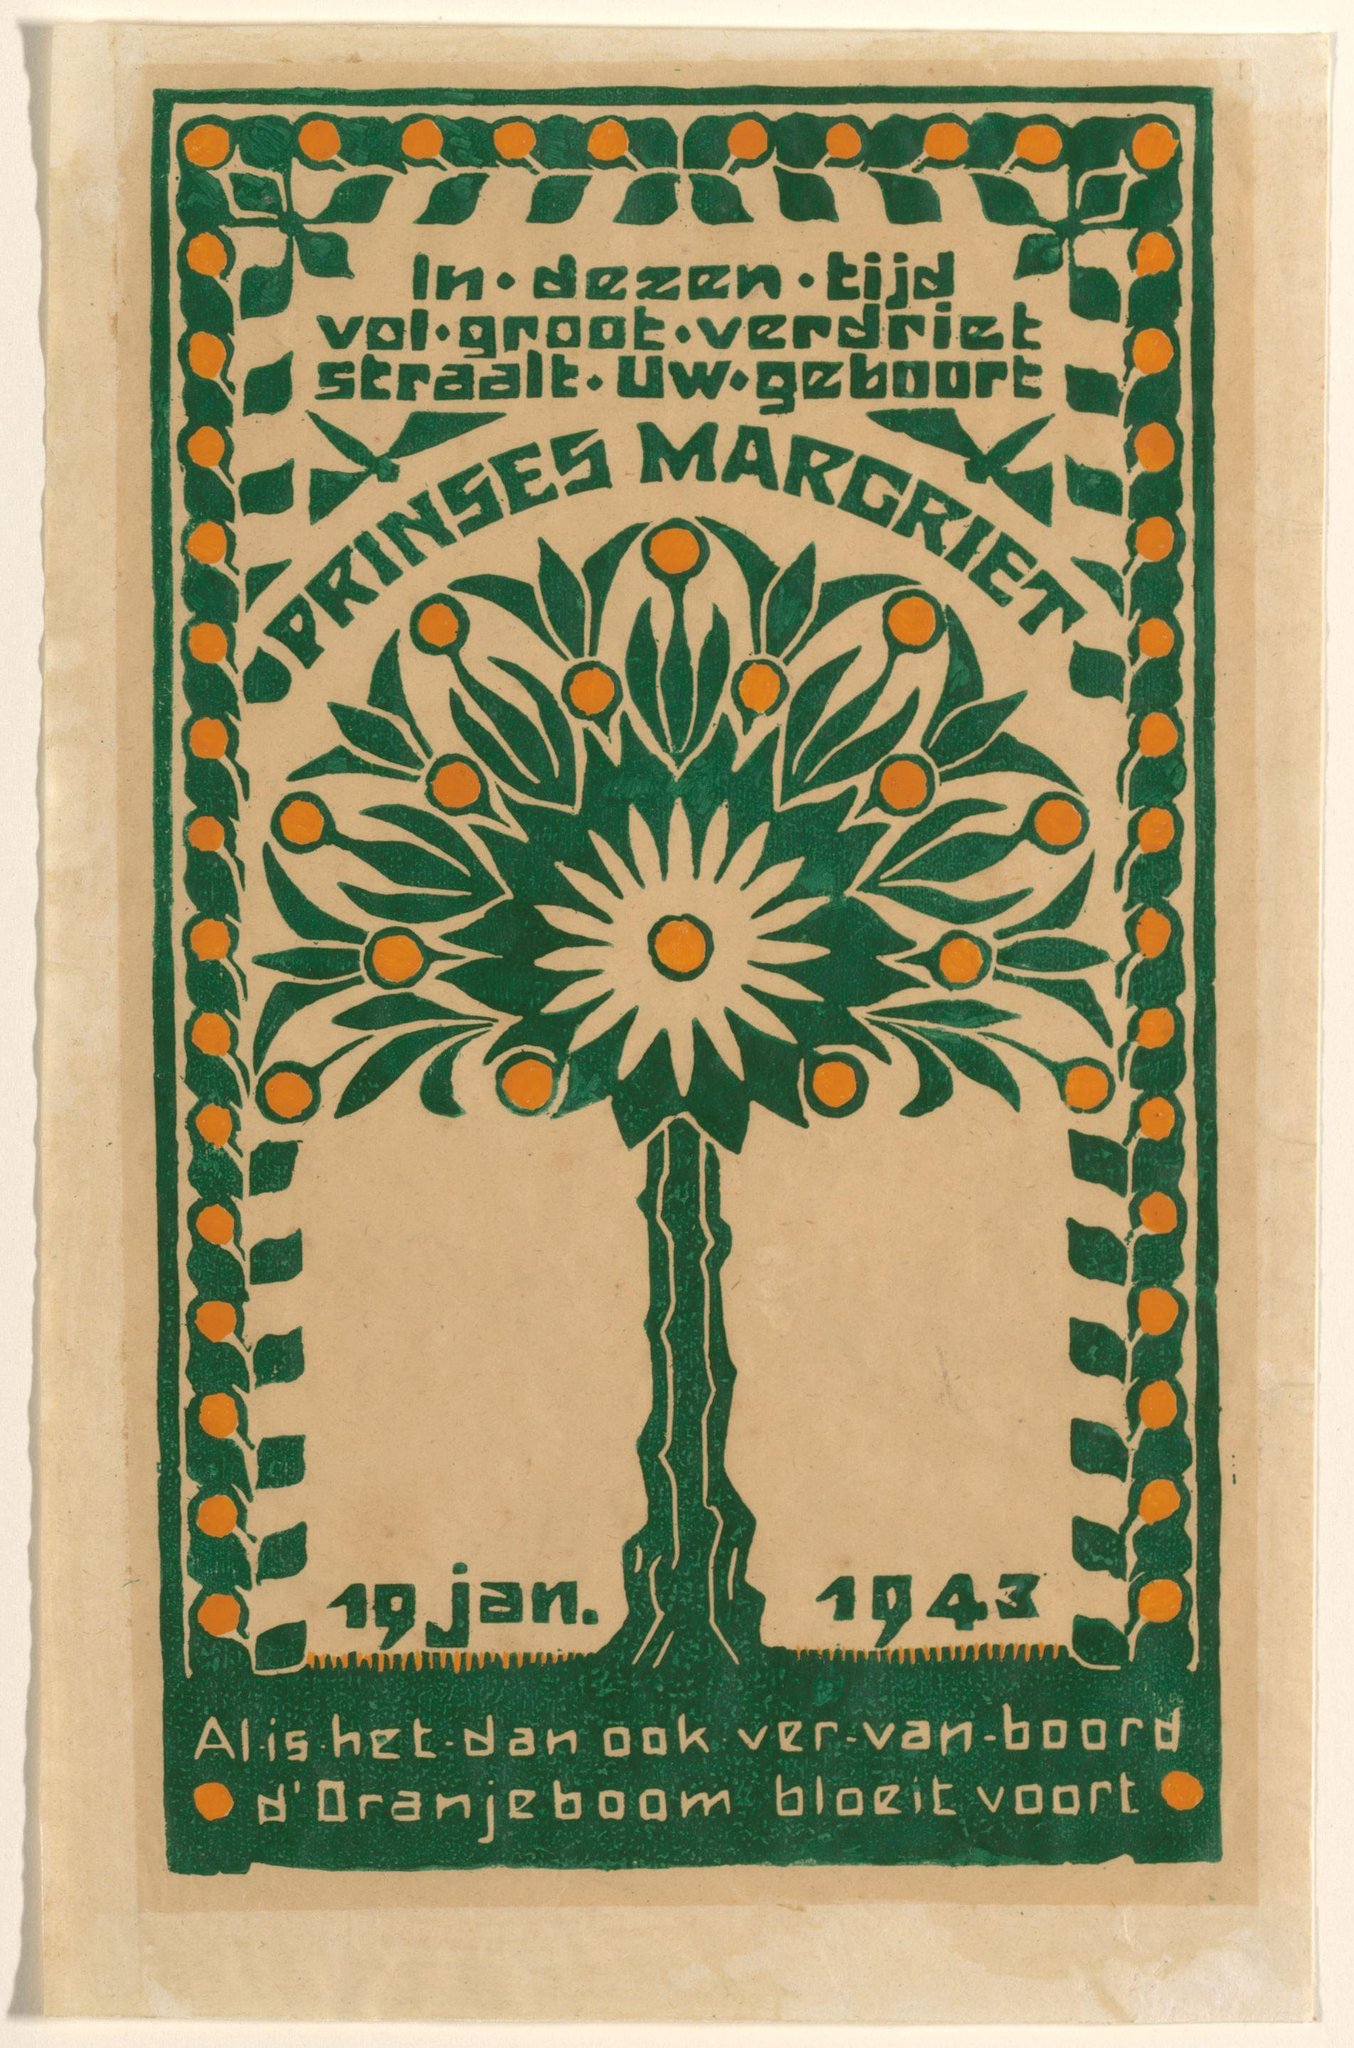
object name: print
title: Gedenkprent bij de geboorte van prinses Margriet, 19 januari 1943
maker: Anonymous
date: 1943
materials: paper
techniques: linocut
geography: netherlands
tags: margriet (prinses der nederlanden)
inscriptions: collector's mark: Lugt 2228, inscription: ‘In deze tijd vol groot verdriet straalt Uw geboort PRINSES MARGRIET. 19 jan. 1943. Al is het dan ook ver van boord d'Oranjeboom bloeit voort’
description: Gedenkprent bij de geboorte van prinses Margriet: 19 januari 1943. Een oranjeboom in een ornamentrand van groene bladmotieven en oranje sinaasappels. Bovenaan de tekst 'In dezen tijd vol groot verdriet straalt Uw geboort Prinses Margriet'. Onderaan: '19 jan. 1943'. Geheel onderaan, in witte letters op een groen fond: 'Al is het dan ook ver van boord d'Oranjeboom bloeit voort'.